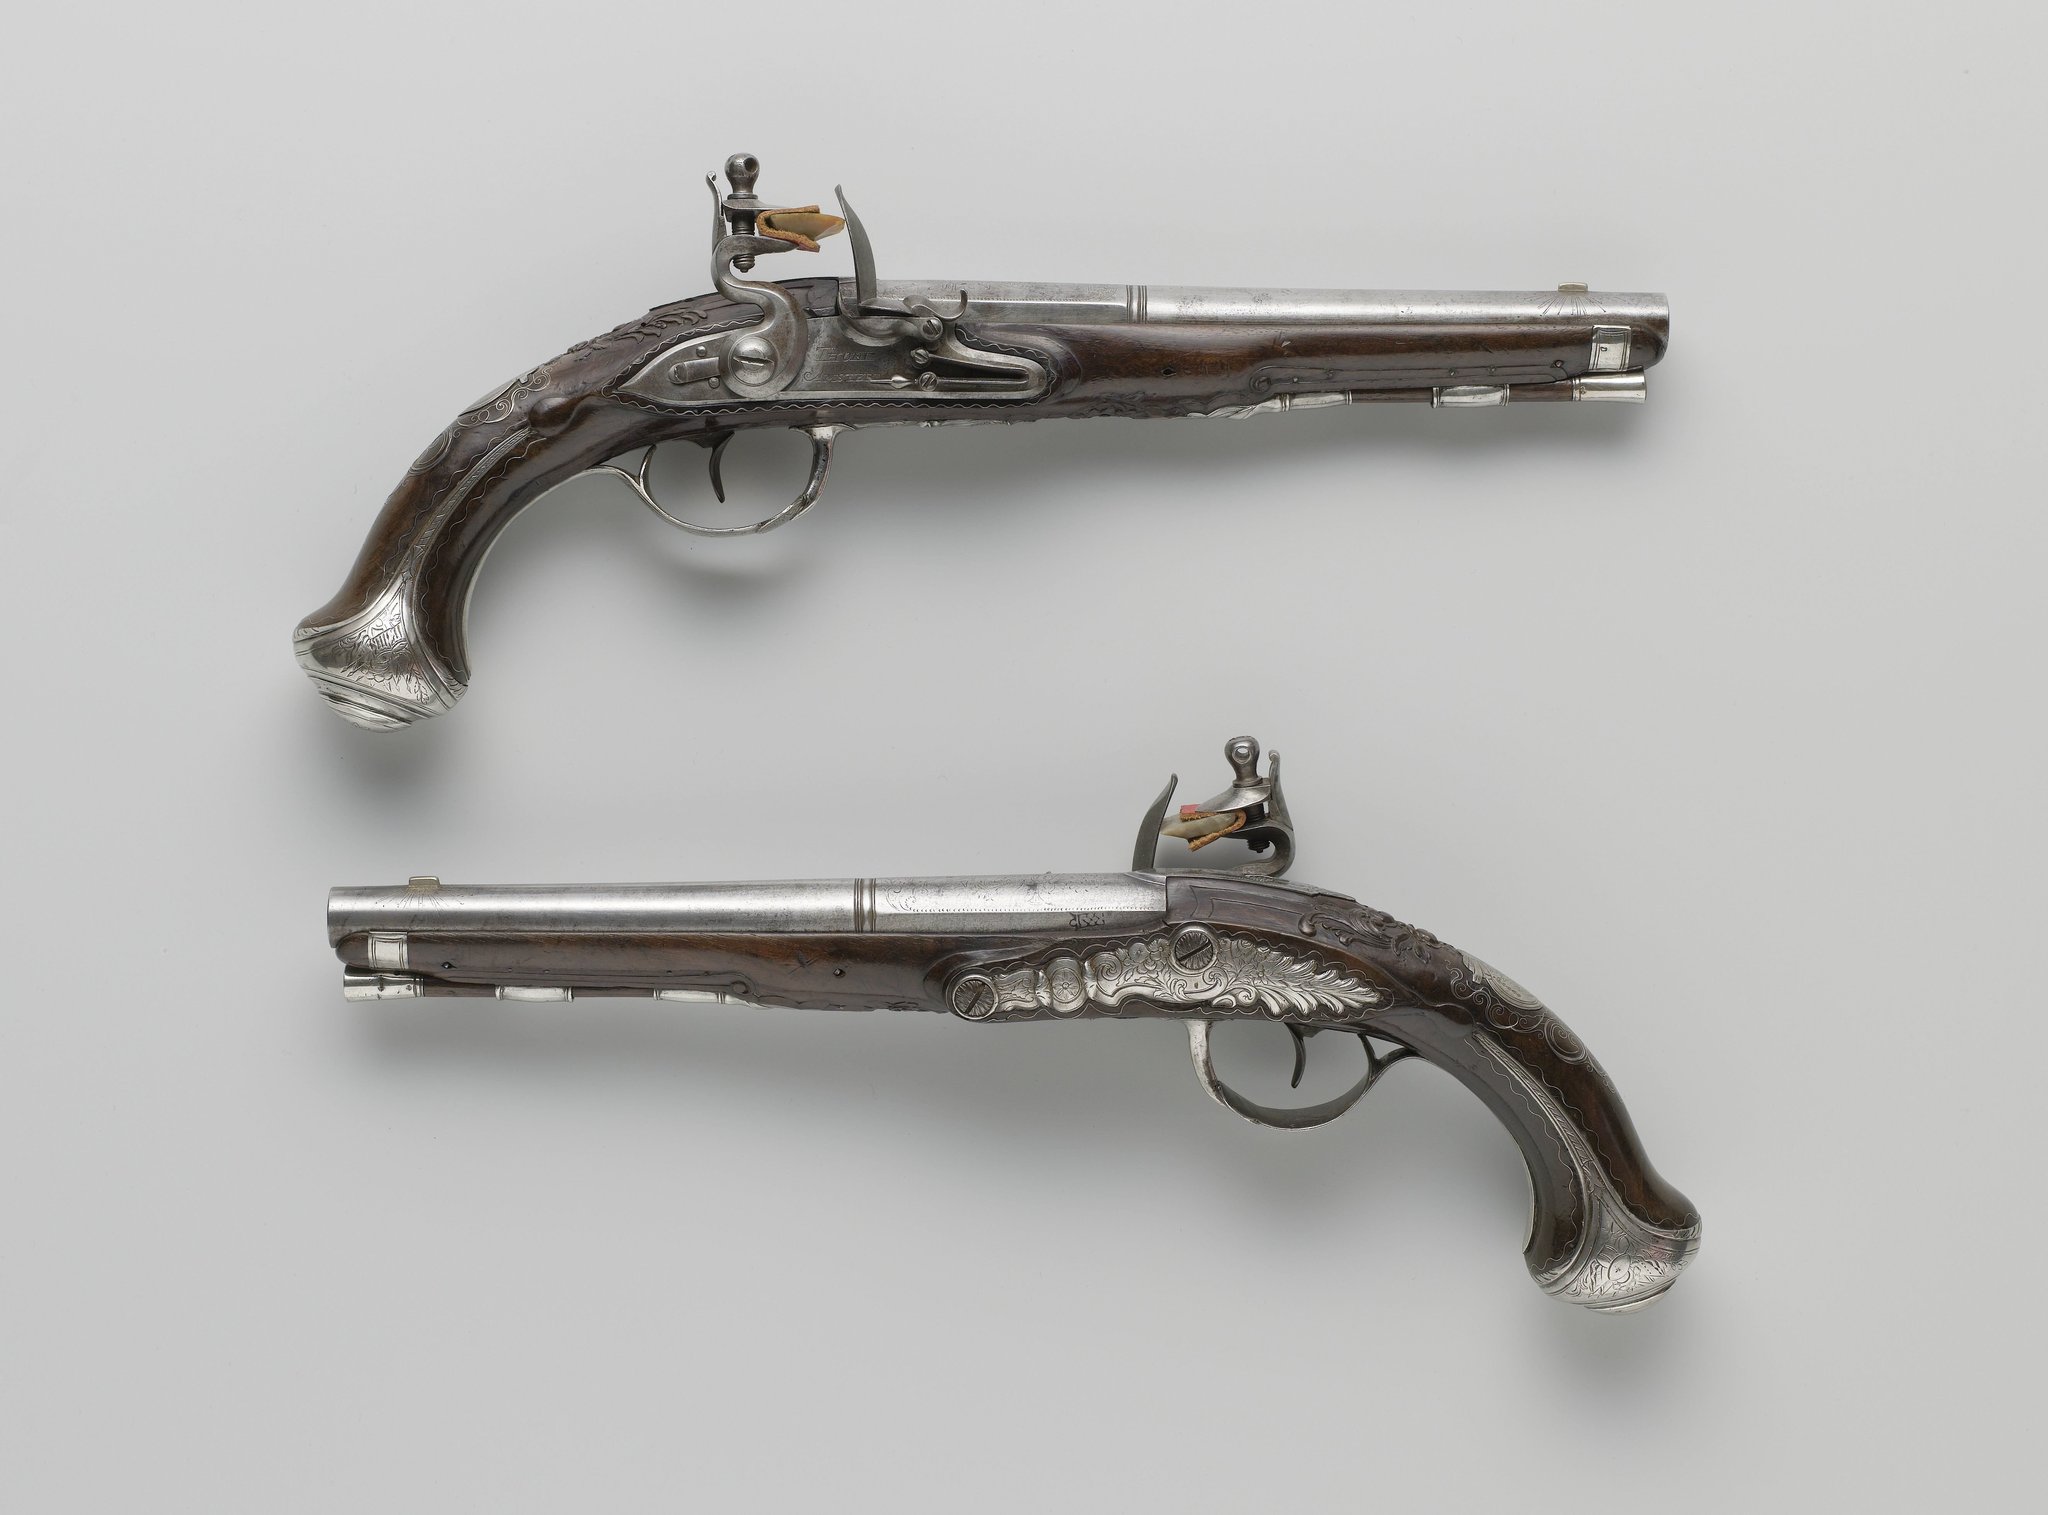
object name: flintlock pistol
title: Vuursteenpistool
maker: lambertus michaelis thone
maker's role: weapon manufacturer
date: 1780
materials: gold, silver, thread, wood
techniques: metalworking, cutting, encrustation, engraving, inlay, striking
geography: amsterdam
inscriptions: coat of arms, coat of arms, signature: ‘THONE // AMSTERDAM’, mark: ‘V’